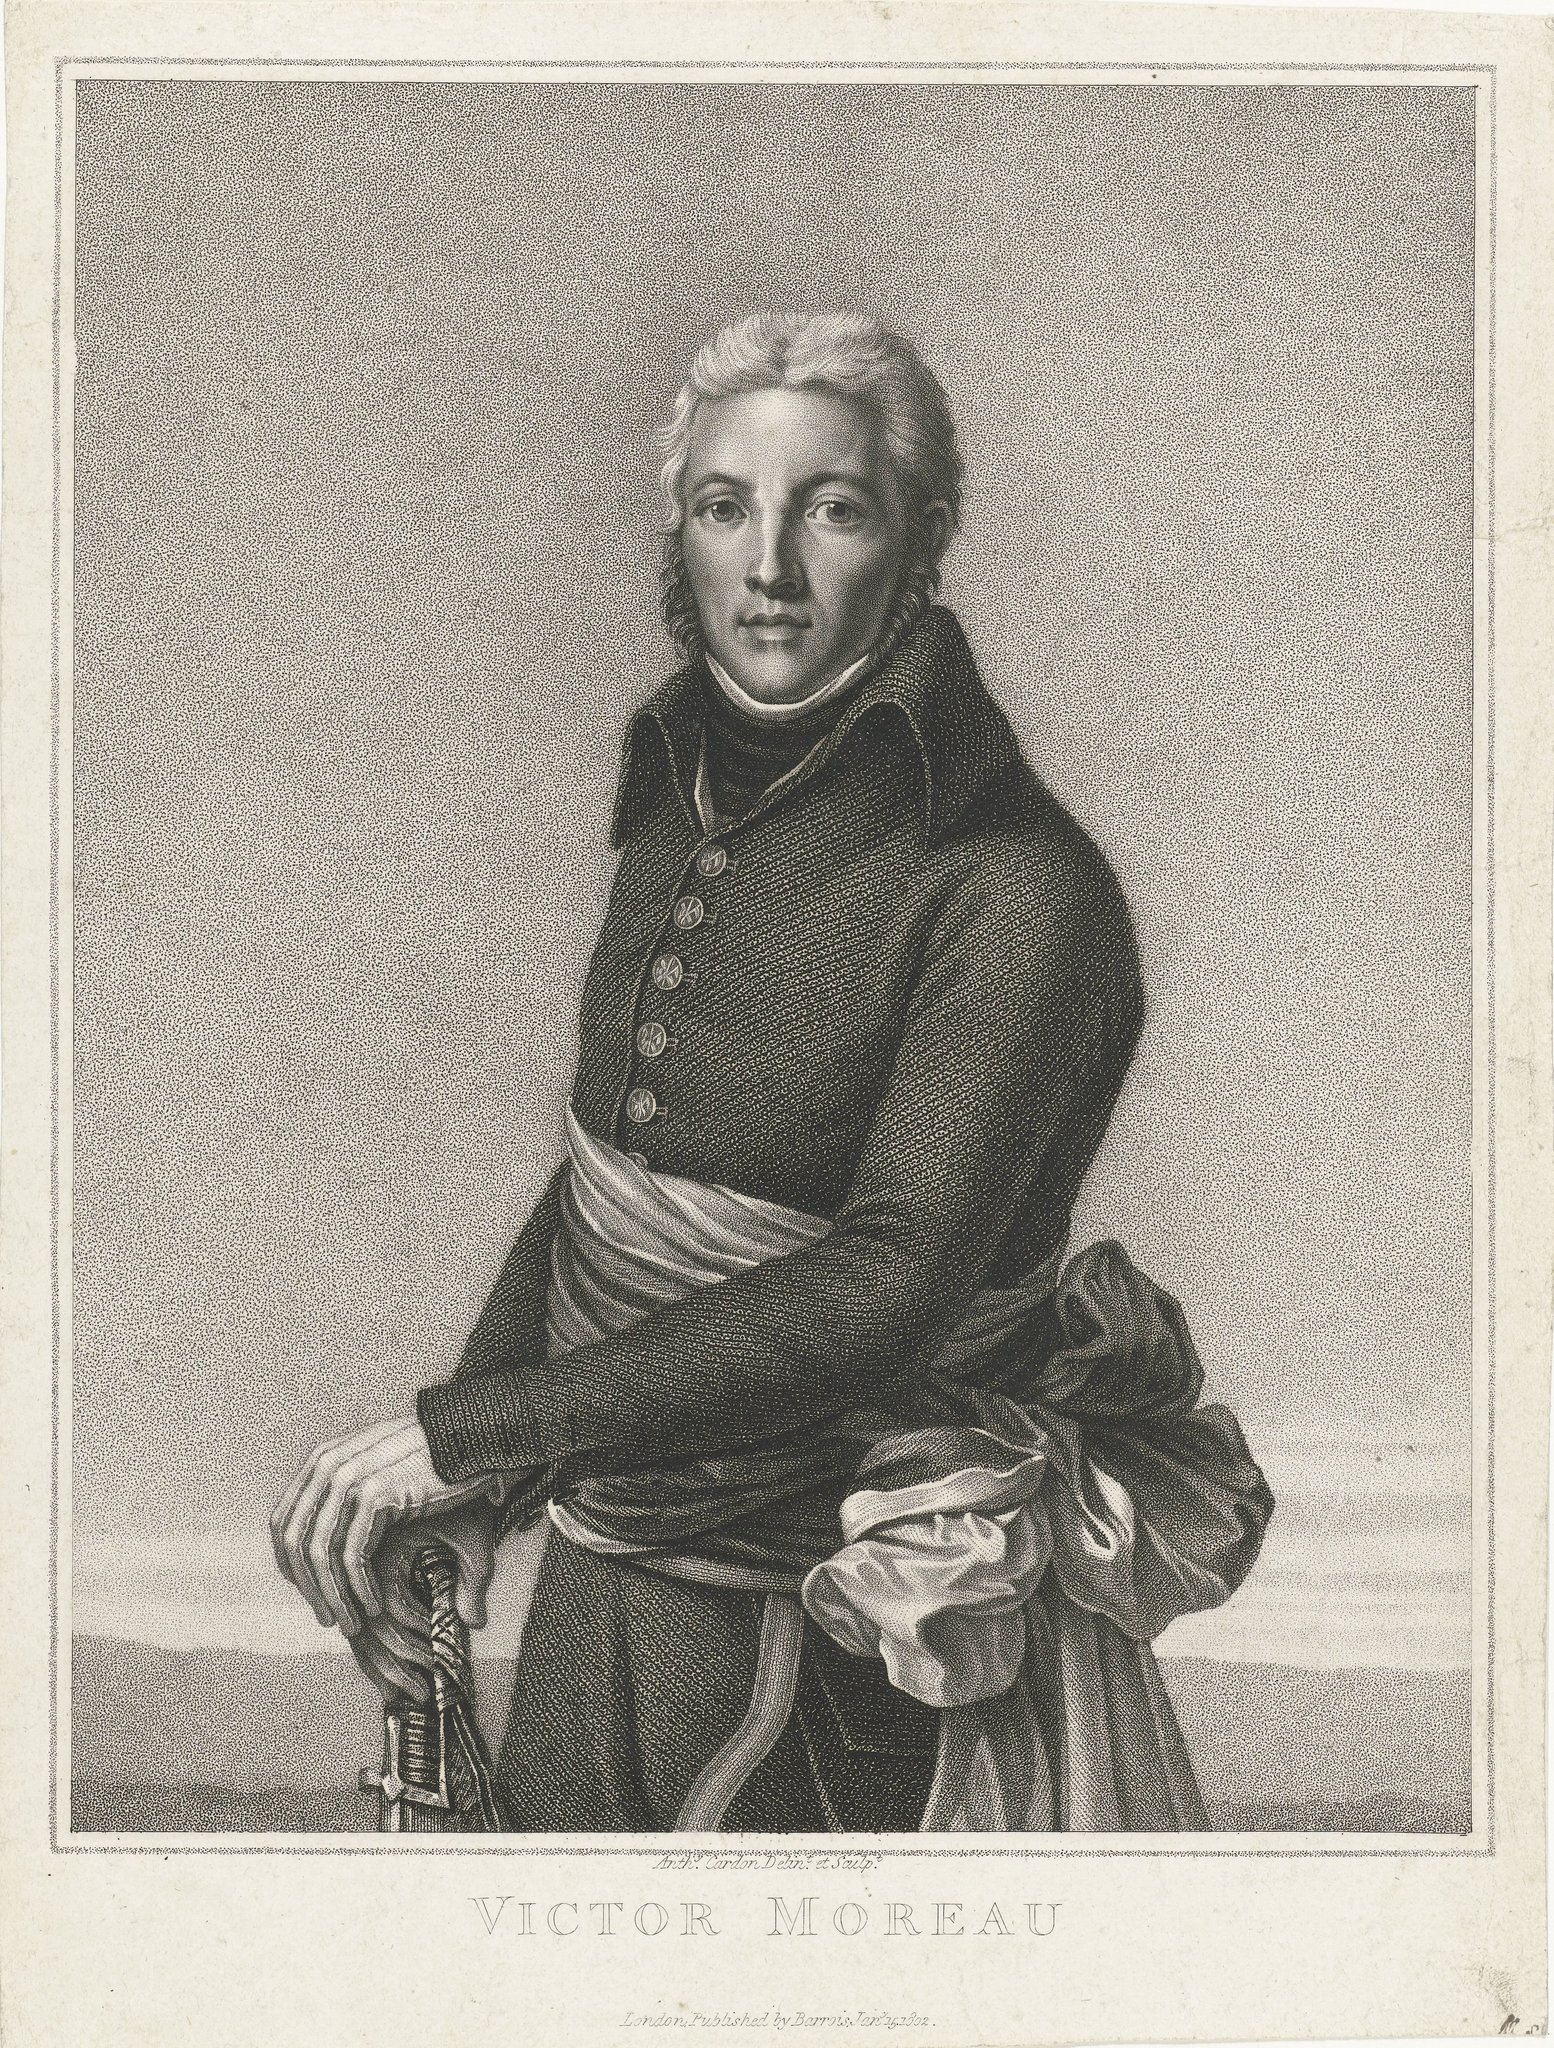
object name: print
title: Portret van generaal Jean Victor Marie Moreau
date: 1802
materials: paper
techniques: etching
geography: london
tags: commander-in-chief, general, marshal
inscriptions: collector's mark: Lugt 2228